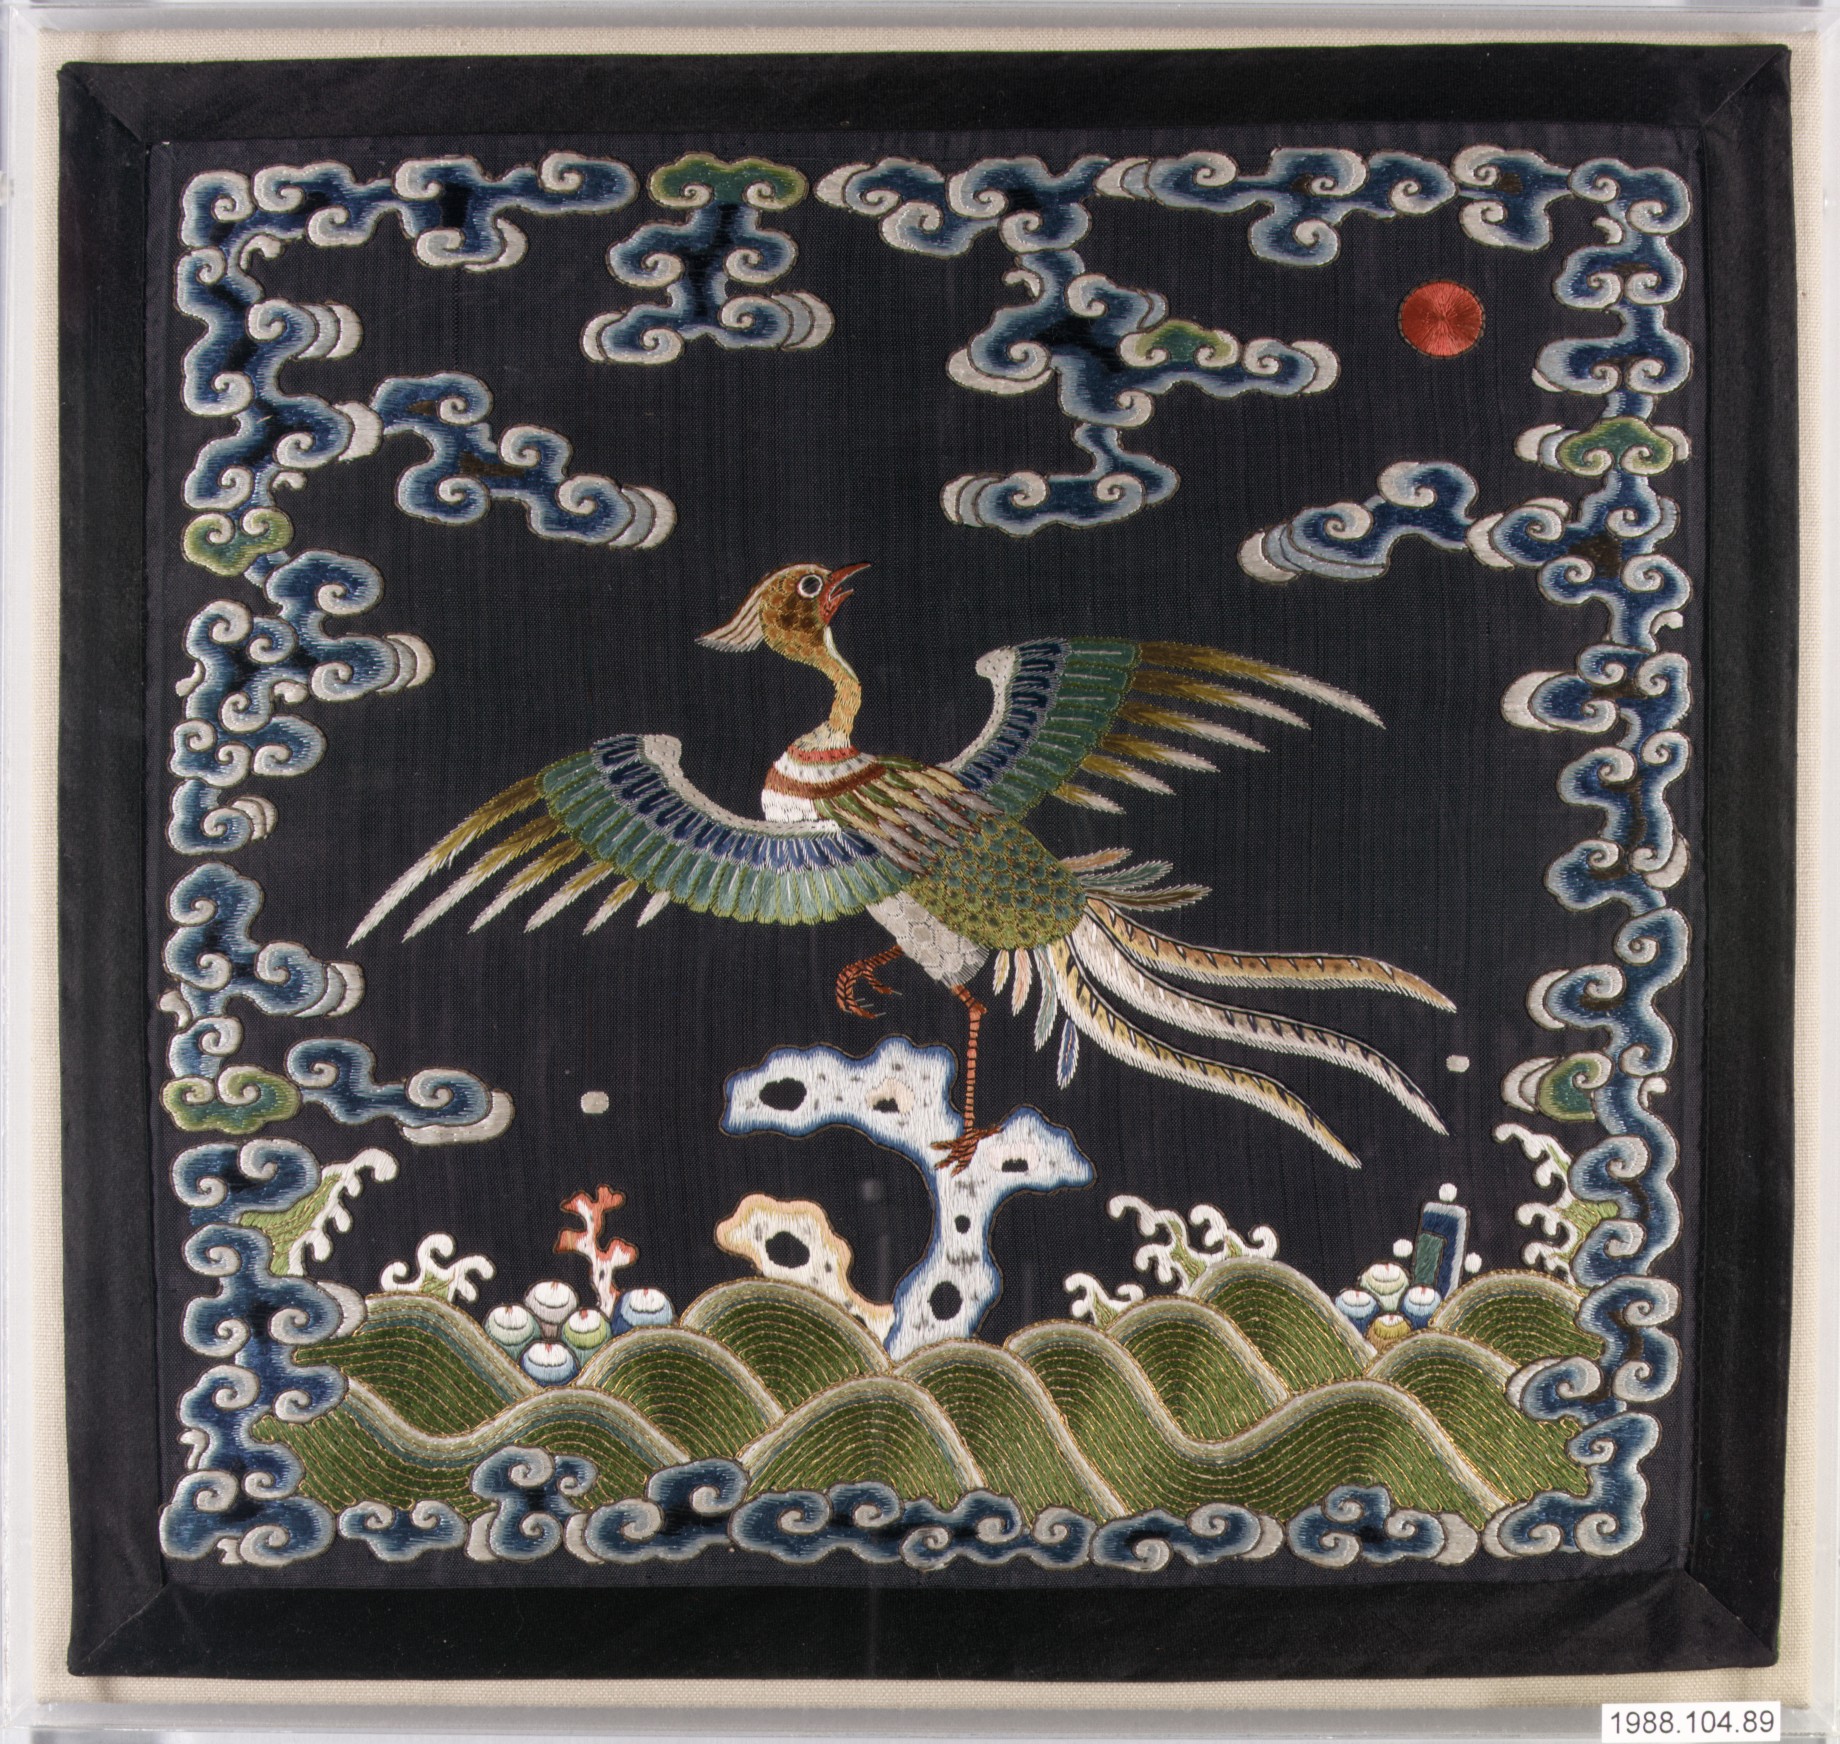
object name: rank badge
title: Rank Badge with Golden Pheasant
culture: chinese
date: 1701-1800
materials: gold, hair, silk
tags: pheasants